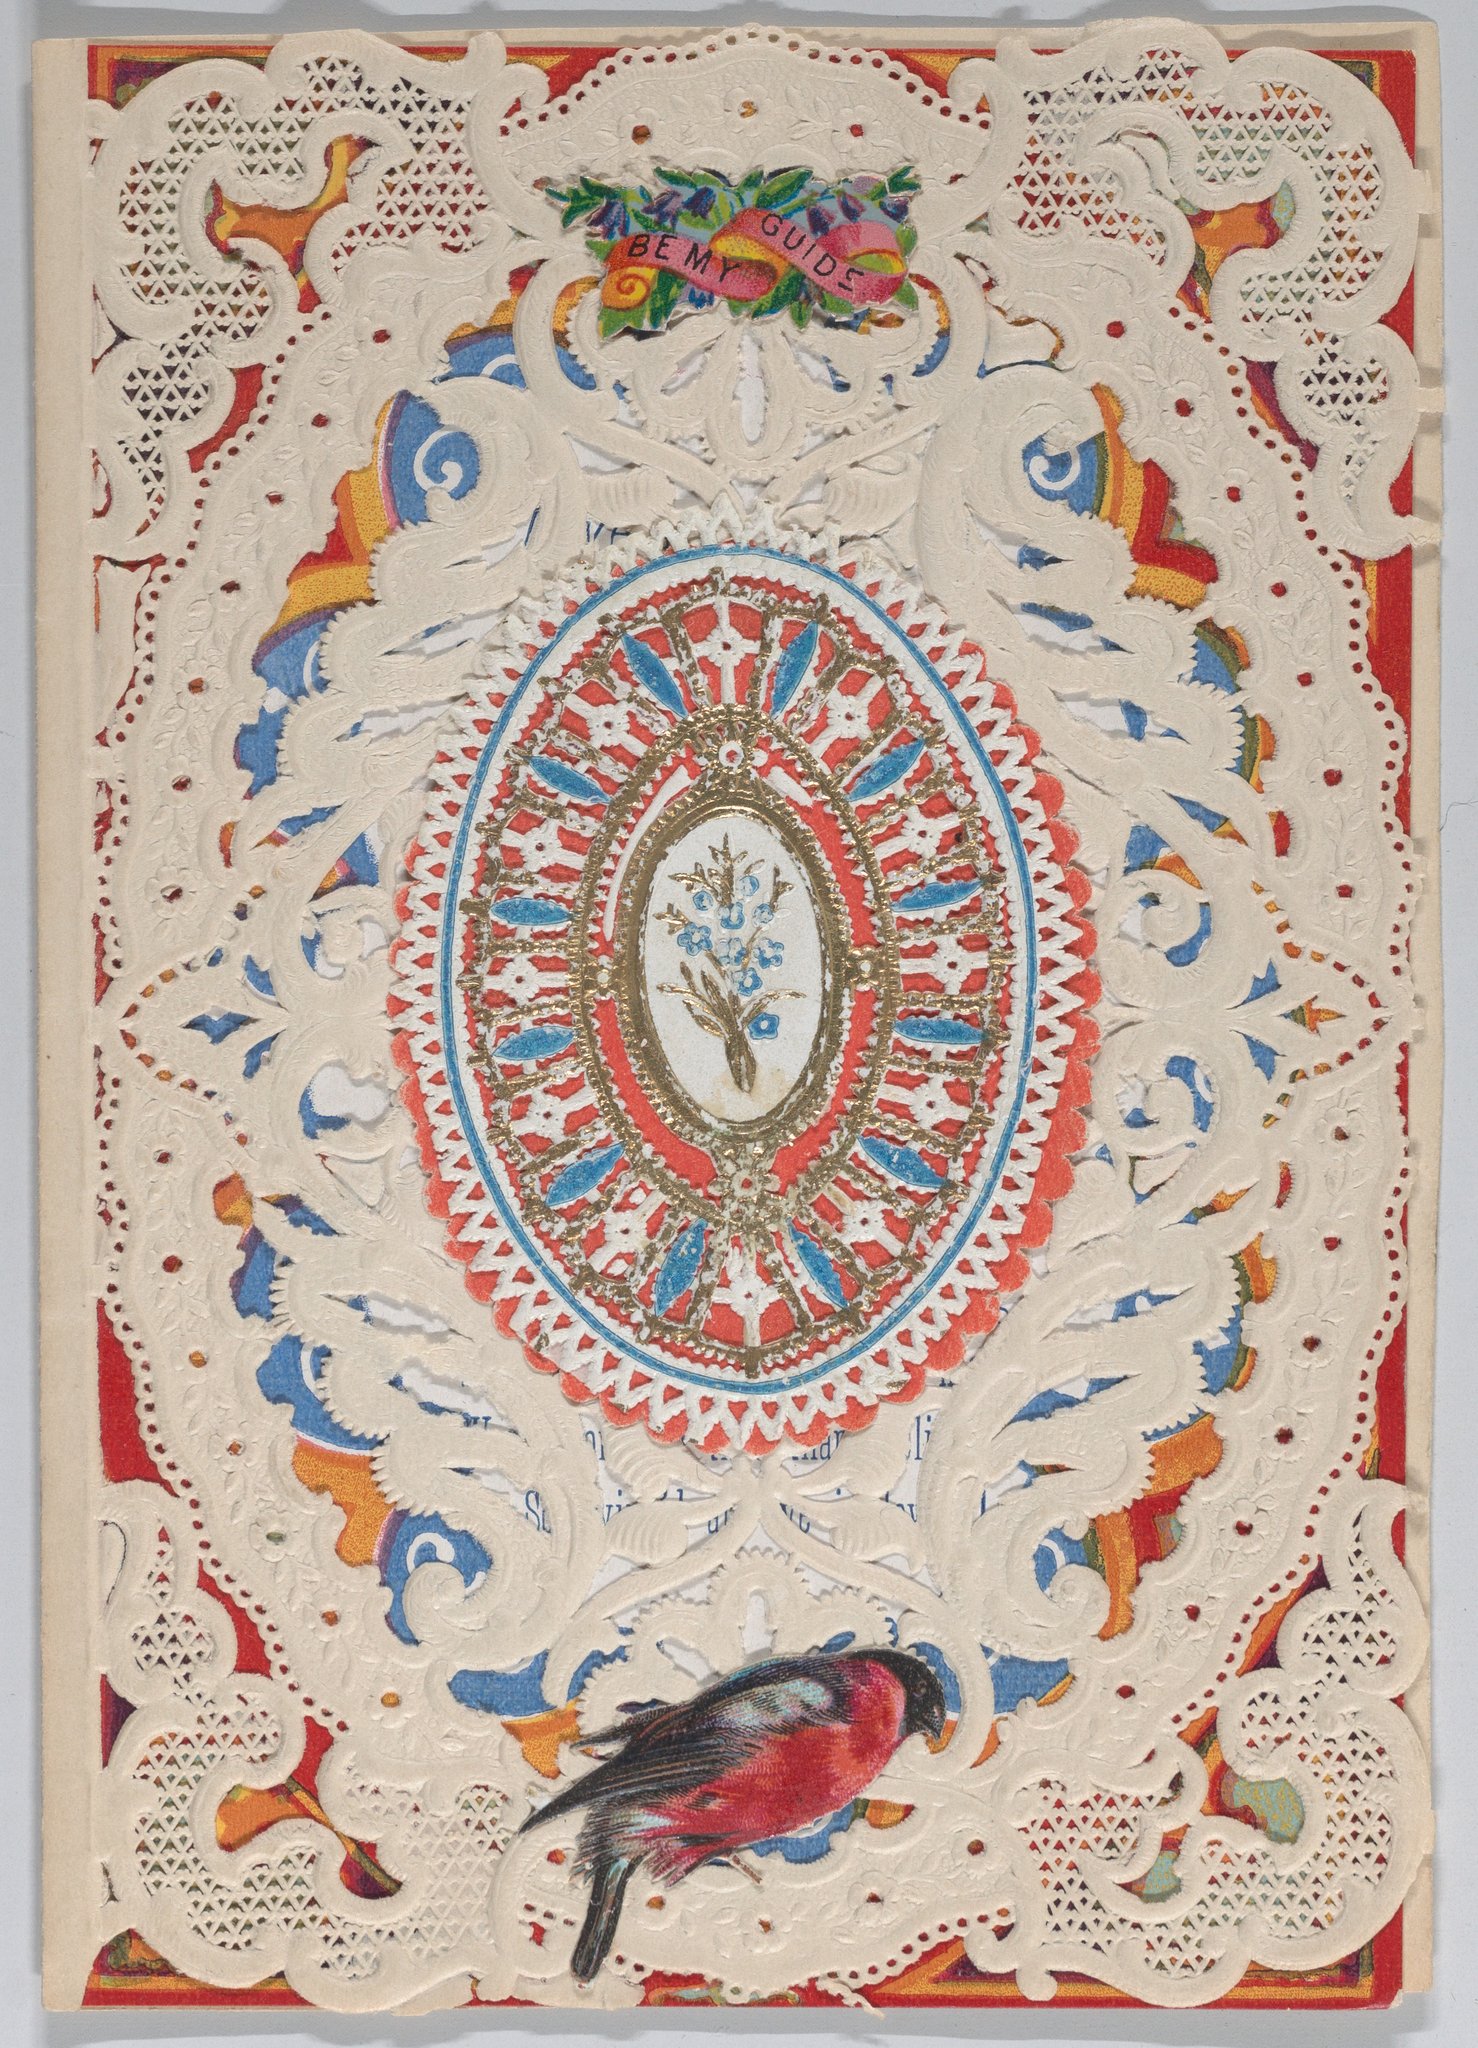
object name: valentine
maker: Anonymous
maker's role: artist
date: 1880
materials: lace, paper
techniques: chromolithography, embossing, open work